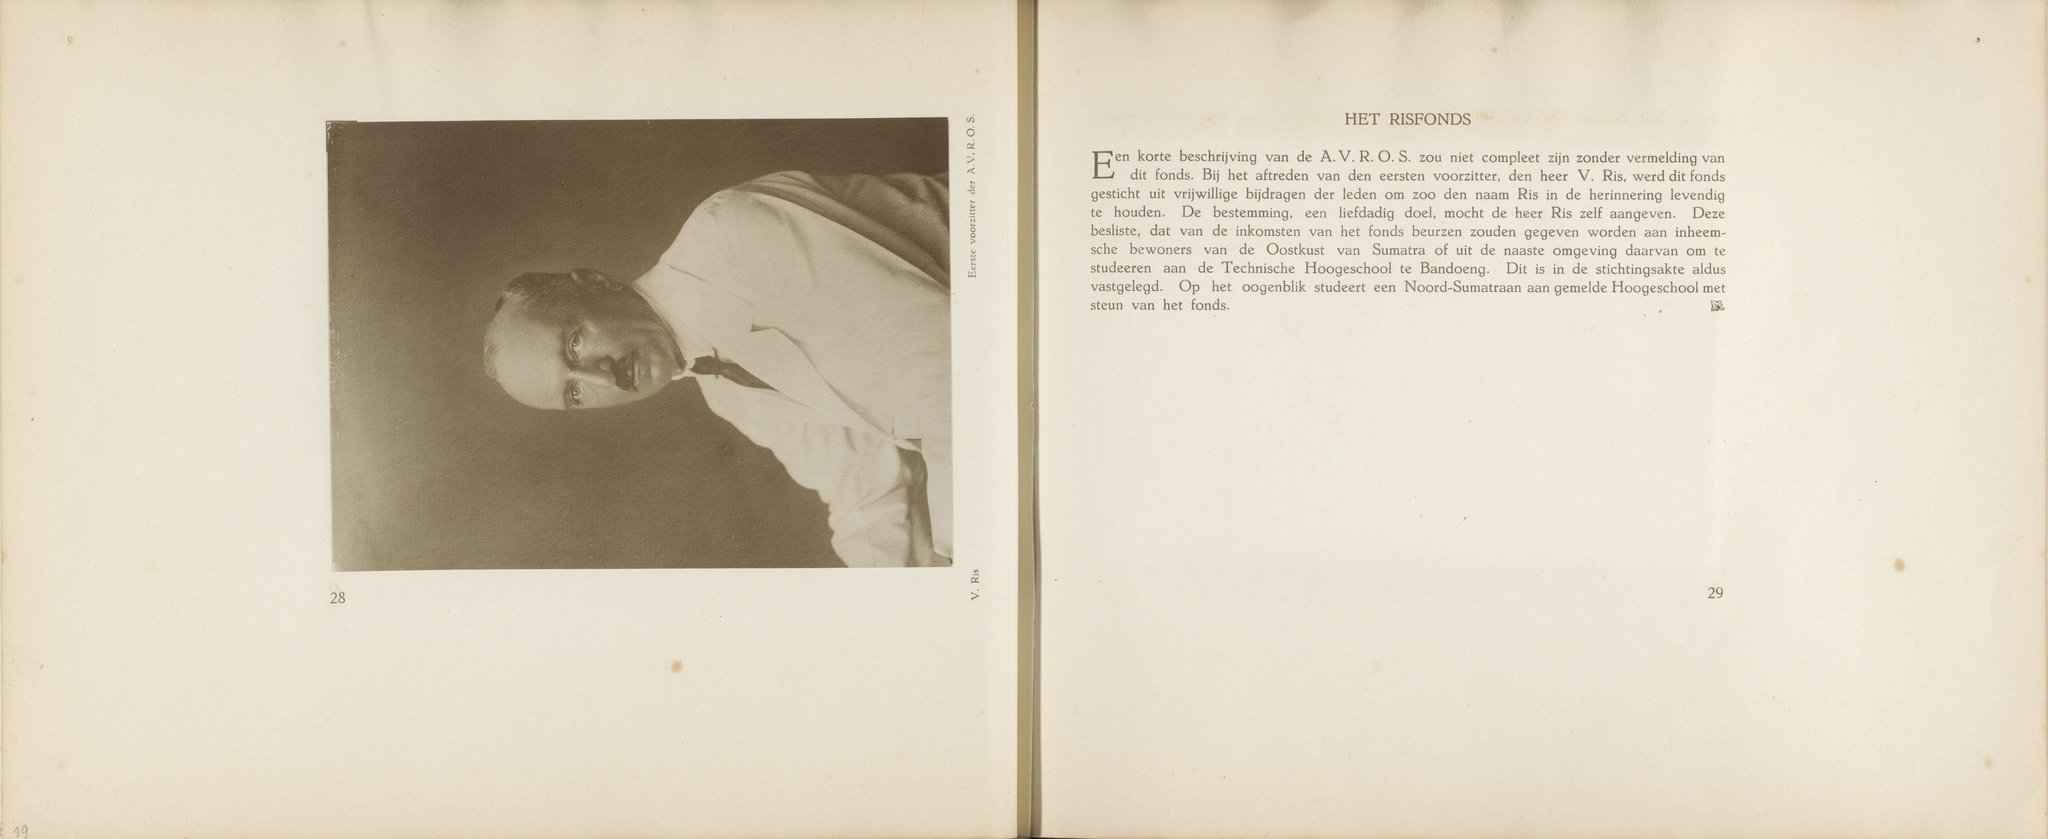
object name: album leaf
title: Pagina 28 en 29 van fotoboek van de Algemeene Vereeniging van Rubberplanters ter Oostkust van Sumatra (A.V.R.O.S.)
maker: j.w. meyster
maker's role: fotograaf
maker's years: 1887-1945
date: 1924-1925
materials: paper, photographic support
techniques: printing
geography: sumatra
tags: (non-fruit) products of plants or trees: rubber, laboratory, public library, sumatra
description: Twee boekpagina's met links een foto van V. Ris, eerste voorzitter van de Algemeene Vereeniging van Rubberplanters ter Oostkust van Sumatra (A.V.R.O.S.). en rechts informatie over het naar hem vernoemde Risfonds. Onderdeel van een fotoboek van de Algemeene Vereeniging van Rubberplanters ter Oostkust van Sumatra (A.V.R.O.S.).